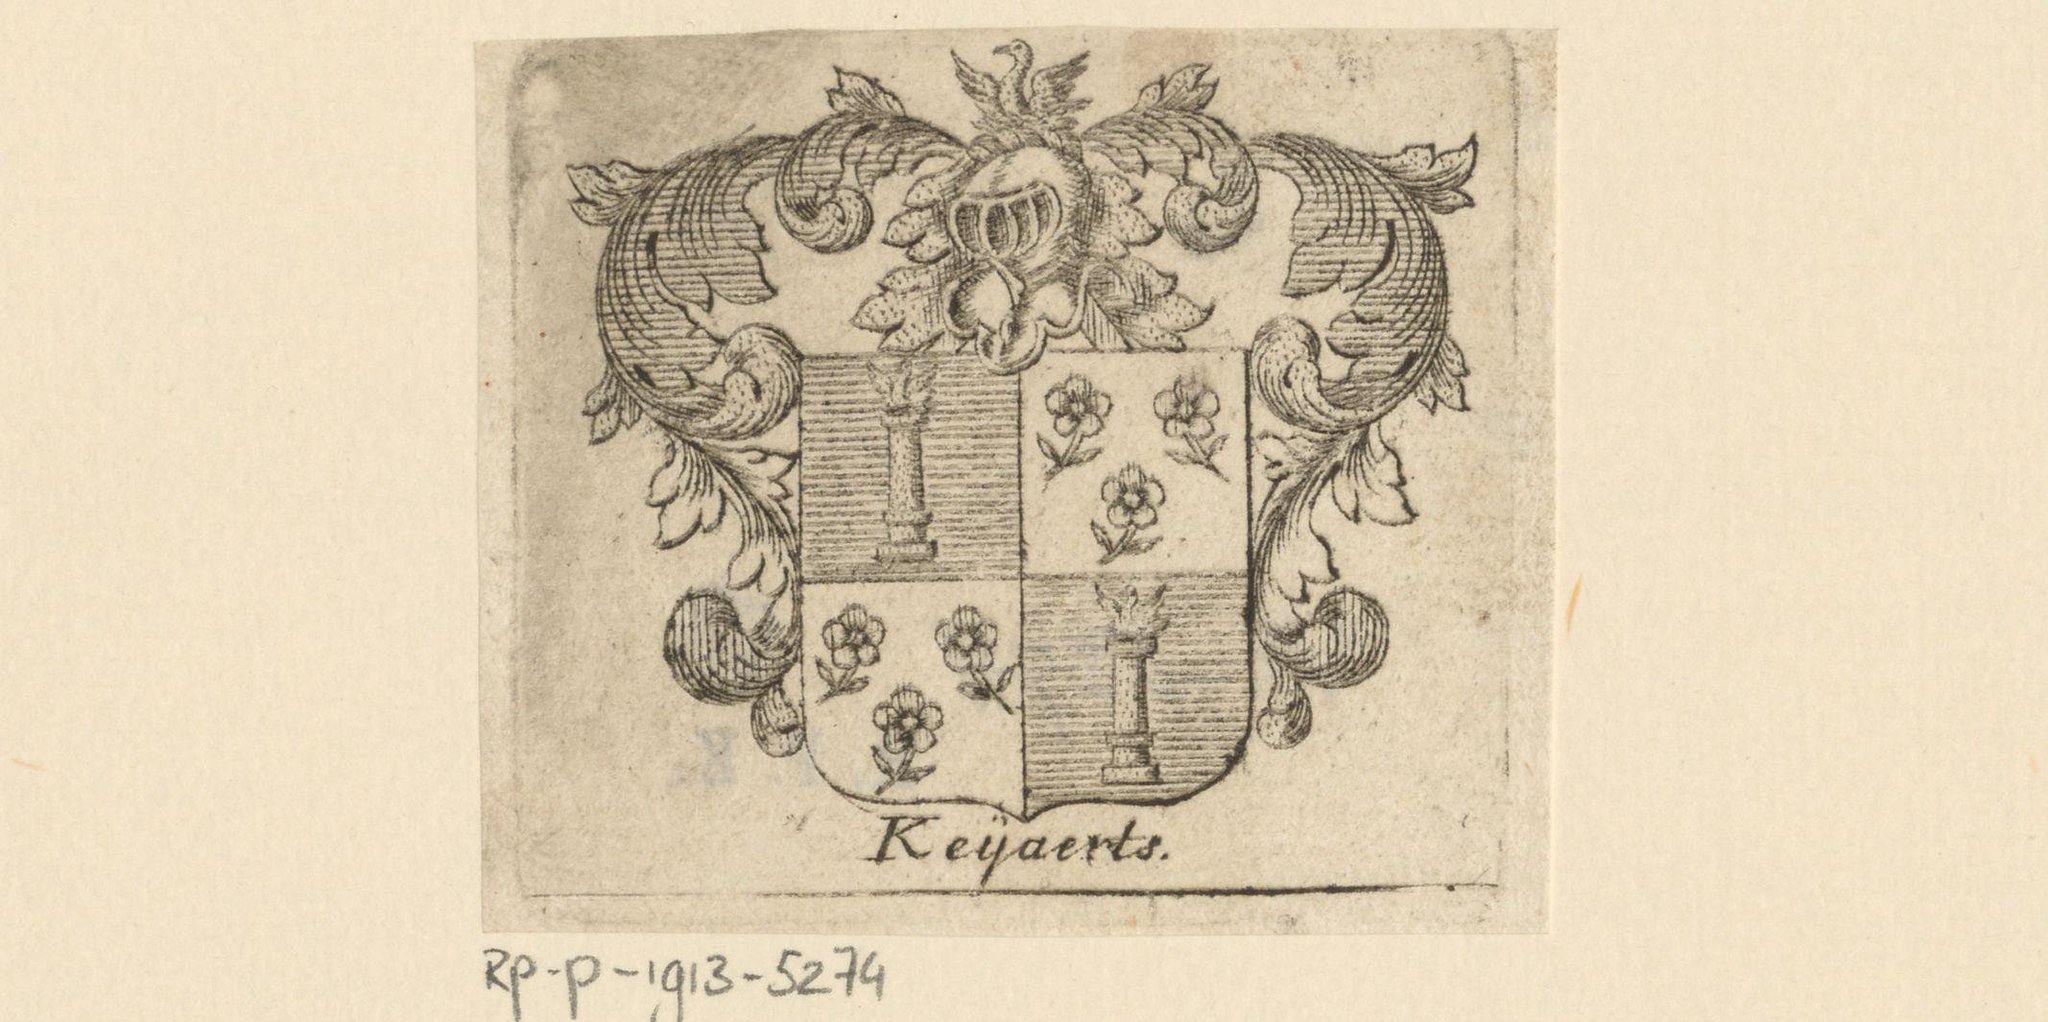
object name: bookplate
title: Ex libris van Keijaerts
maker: Anonymous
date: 1650-1749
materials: paper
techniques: etching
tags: armorial bearing, heraldry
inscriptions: collector's mark: Lugt 2760, collector's mark: Lugt 2233